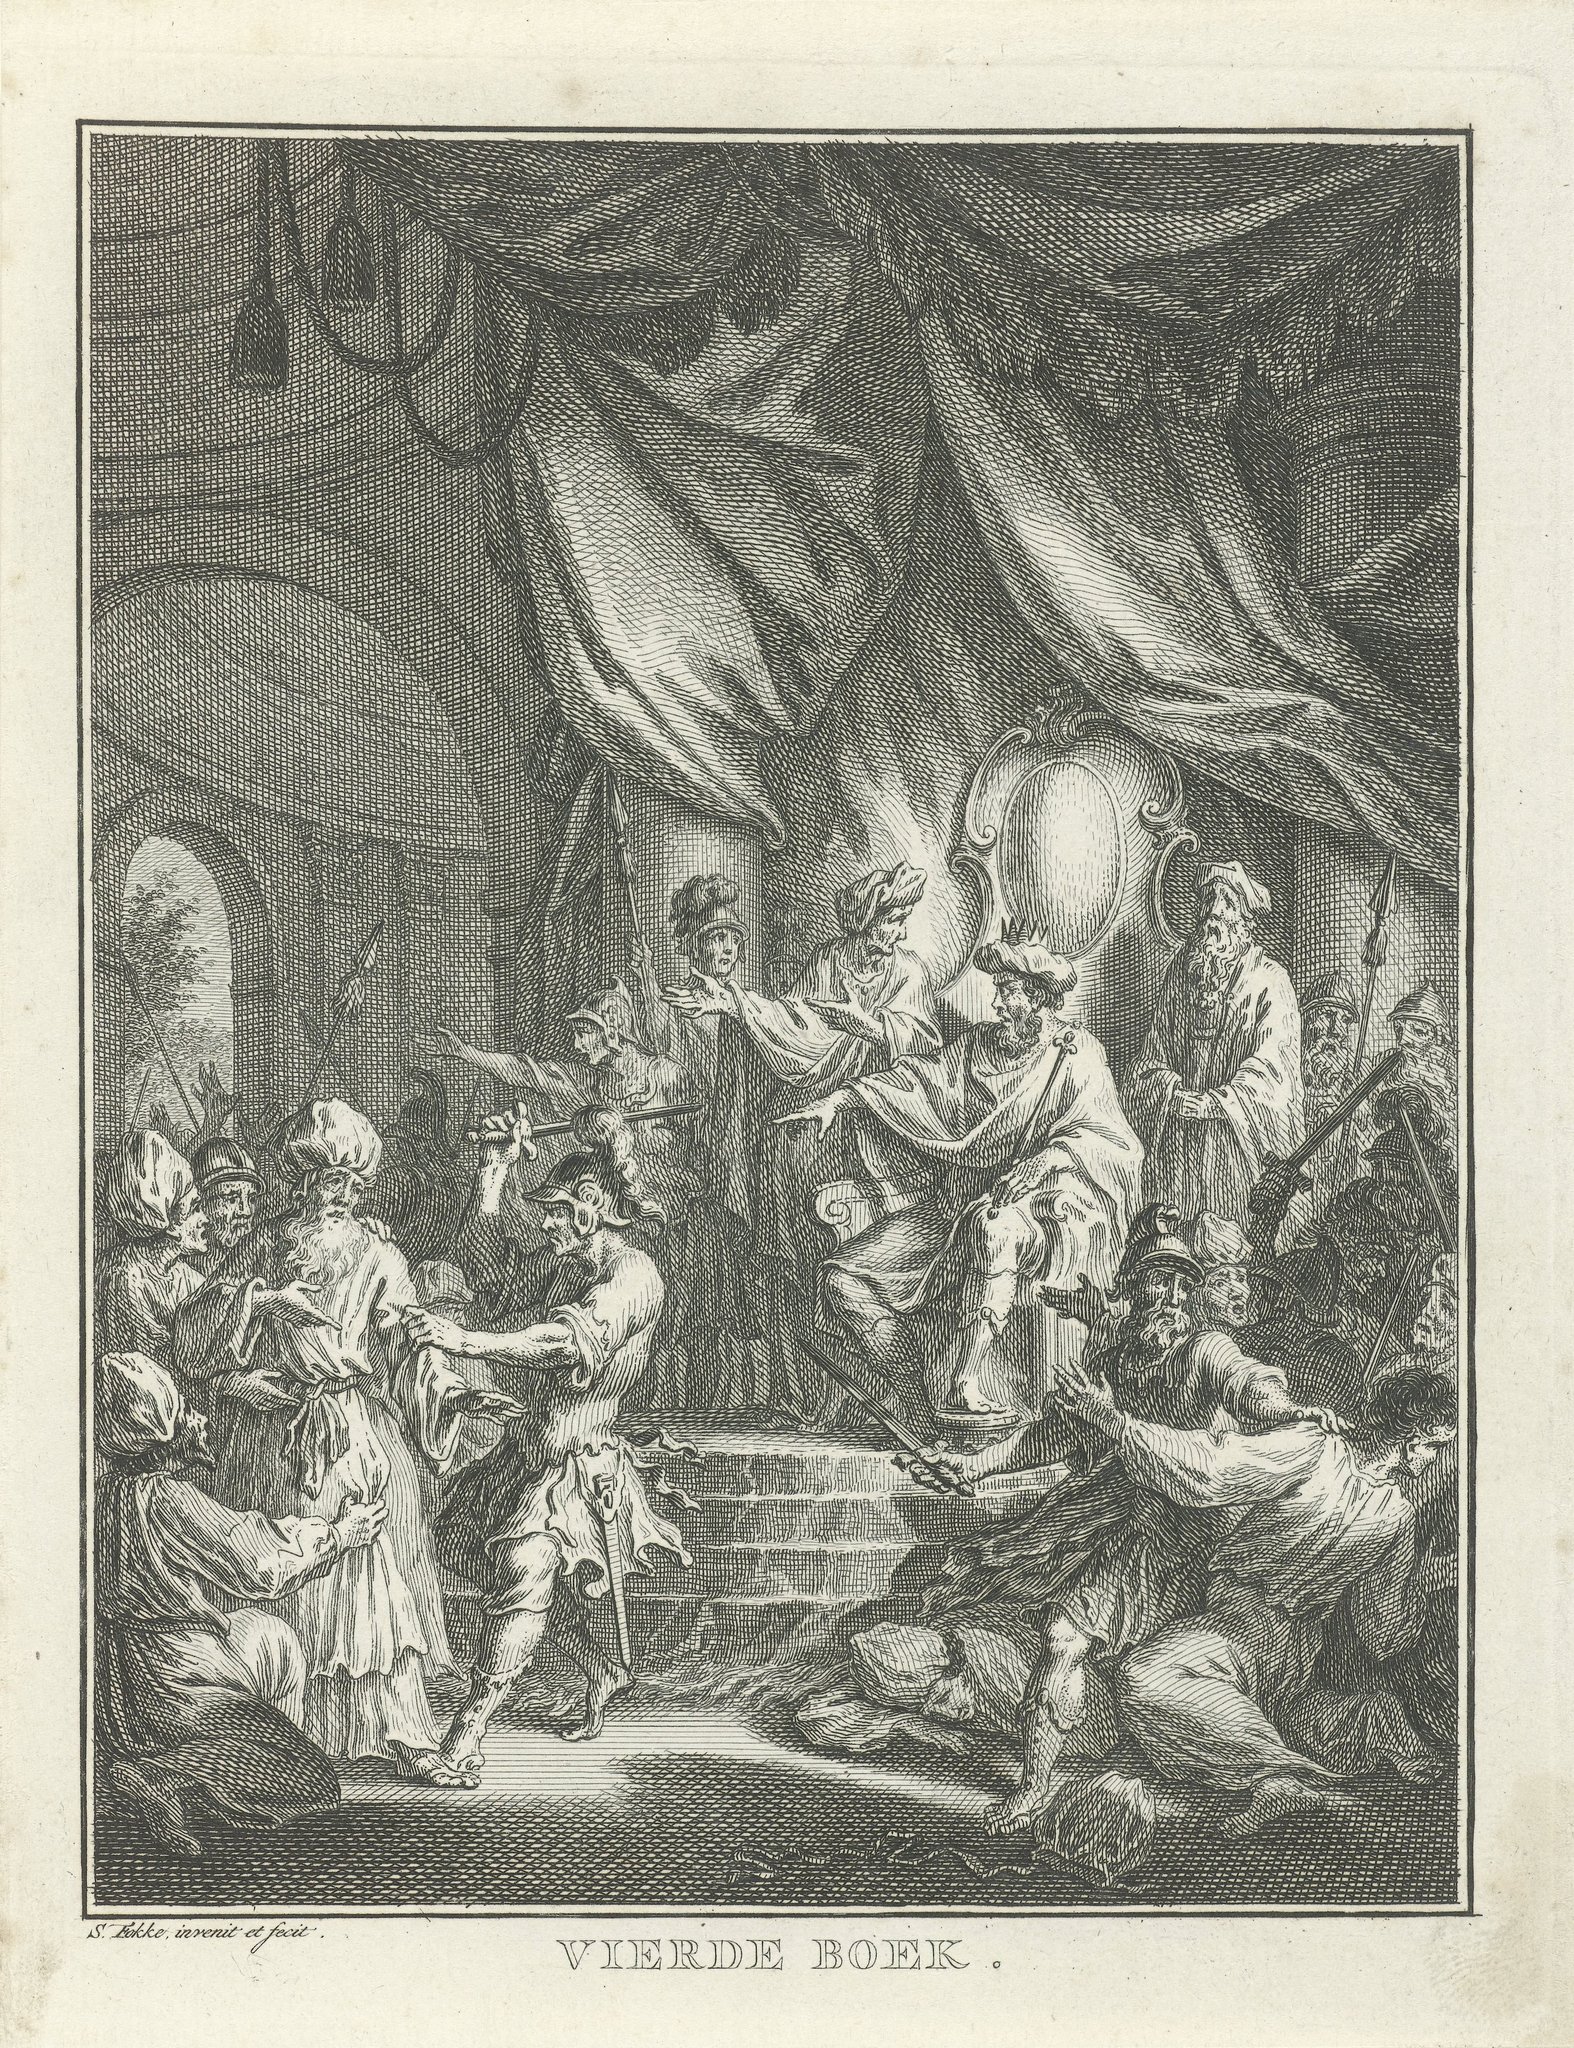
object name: print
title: Vierde Boek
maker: simon fokke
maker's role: draughtsman, print maker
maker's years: 1712-1784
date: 1766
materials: paper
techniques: etching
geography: amsterdam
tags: the inhabitants of nob are killed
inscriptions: collector's mark: Lugt 2228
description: Koning Saul zit op zijn troon en geeft zijn soldaten de opdracht de priesters en andere inwoners van Nob te doden. Rondom de troon gaan de soldaten de omstanders met dolken te lijf. De prent maakt deel uit van een serie over het verhaal van David en Saul.